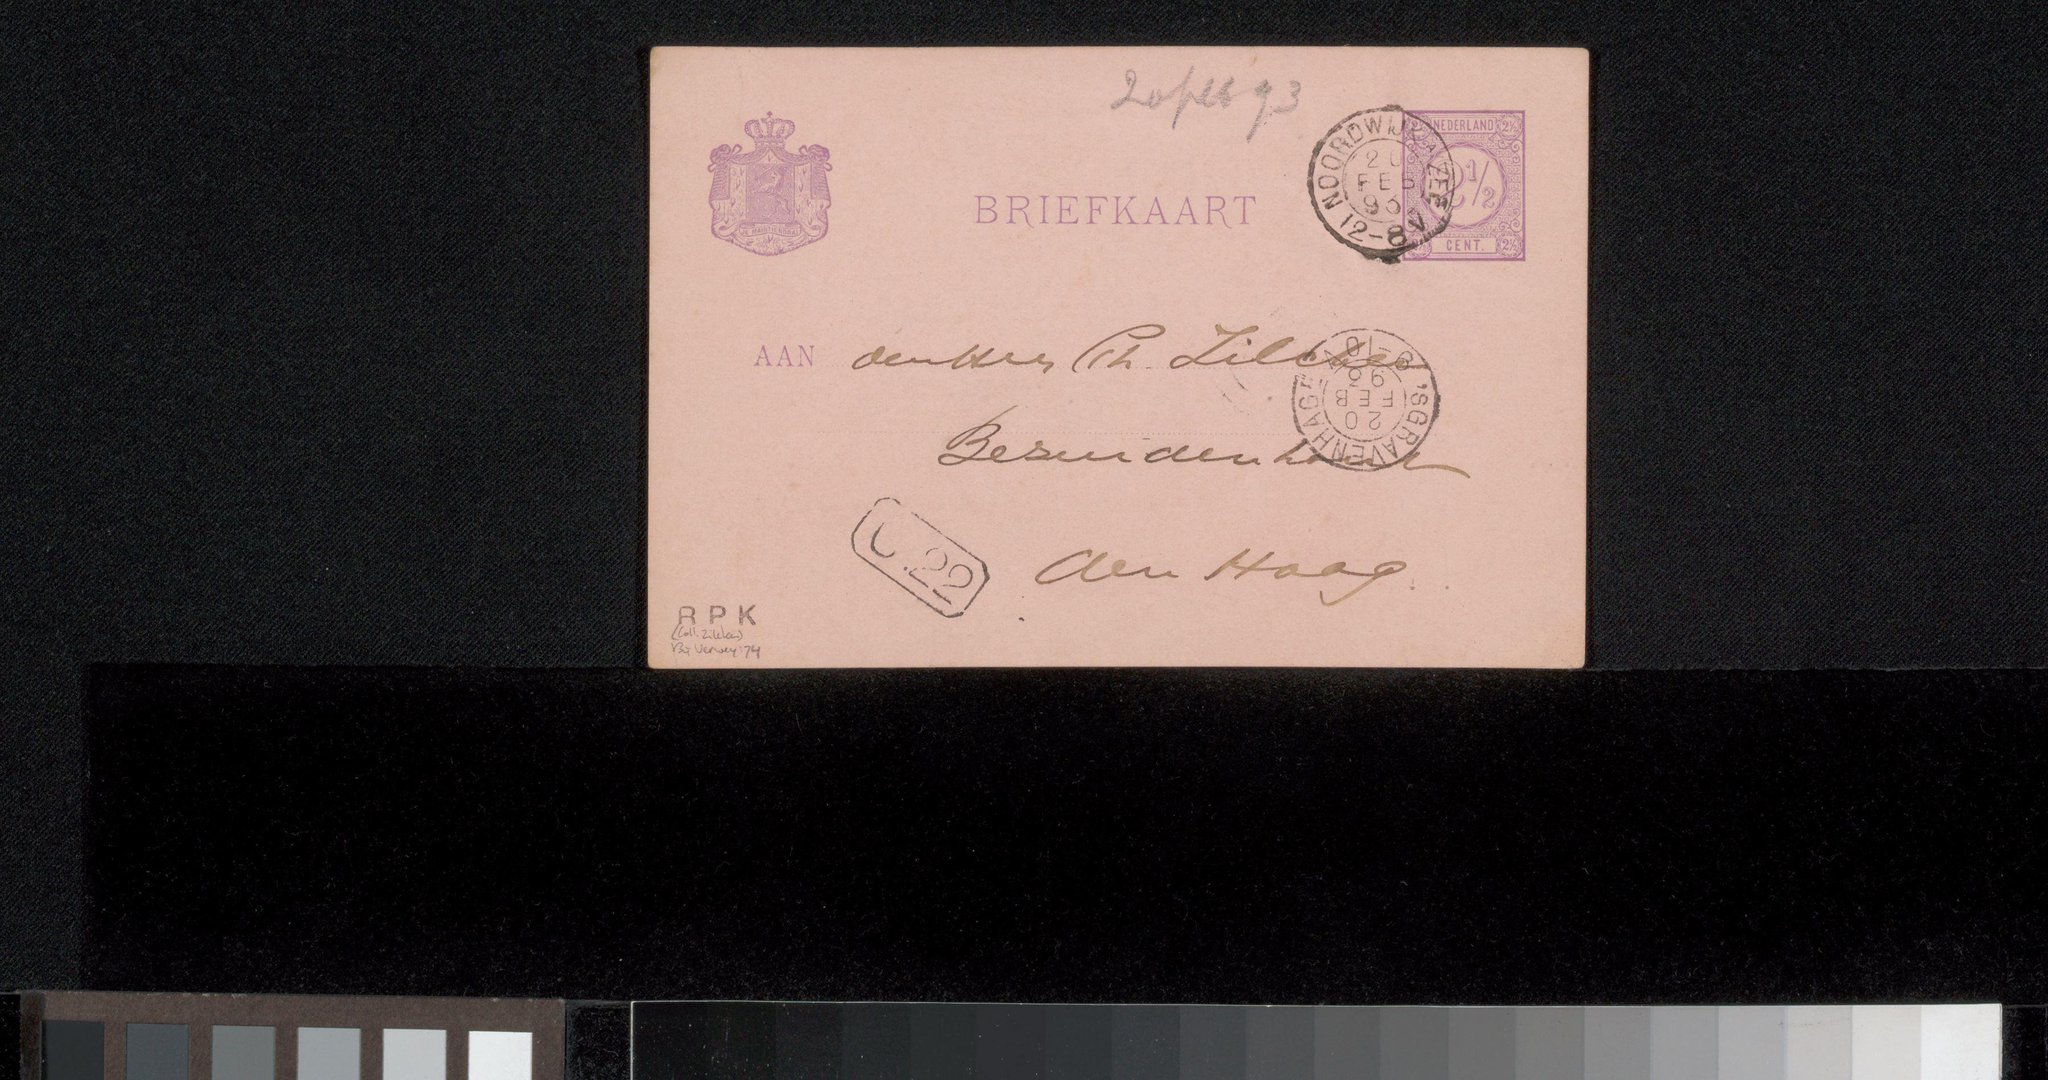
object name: postcard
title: Briefkaart aan Philip Zilcken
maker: albert verwey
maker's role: criticus, dichter, essayist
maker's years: 1865-1937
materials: cardboard, ink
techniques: pen, writing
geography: noordwijk aan zee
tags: the hague, painter, draughtsman, philip zilcken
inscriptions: collector's mark: ‘RPK’